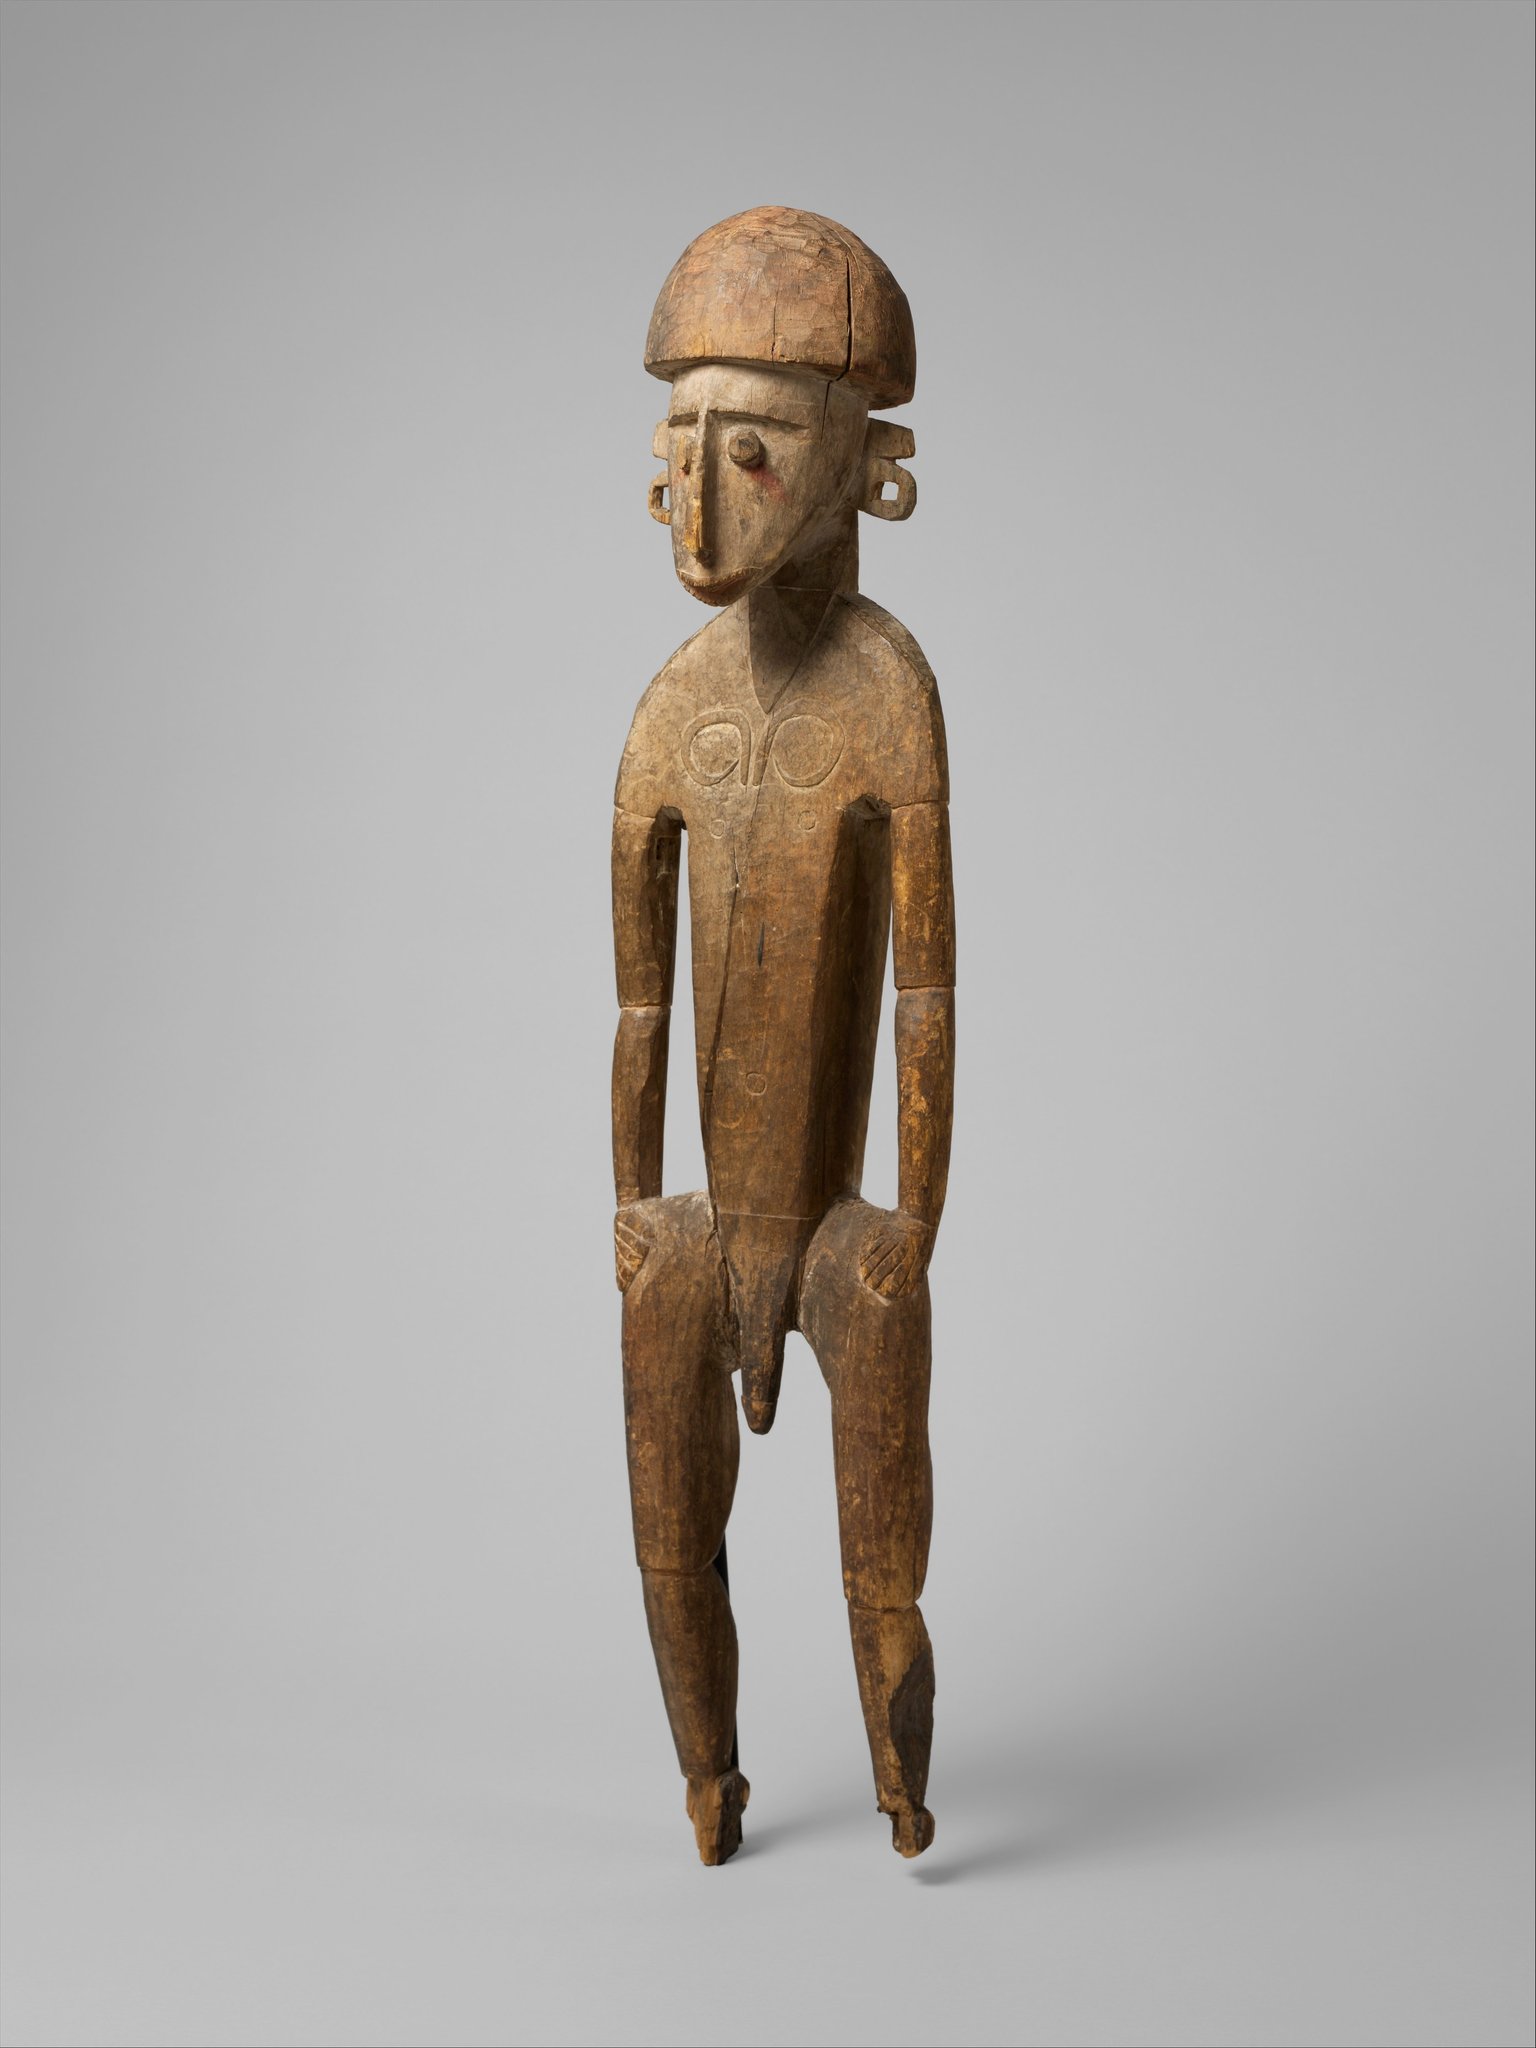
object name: figure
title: Ancestor Figure (Silum or Telum)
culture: anjam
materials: paint, wood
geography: papua new guinea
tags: men